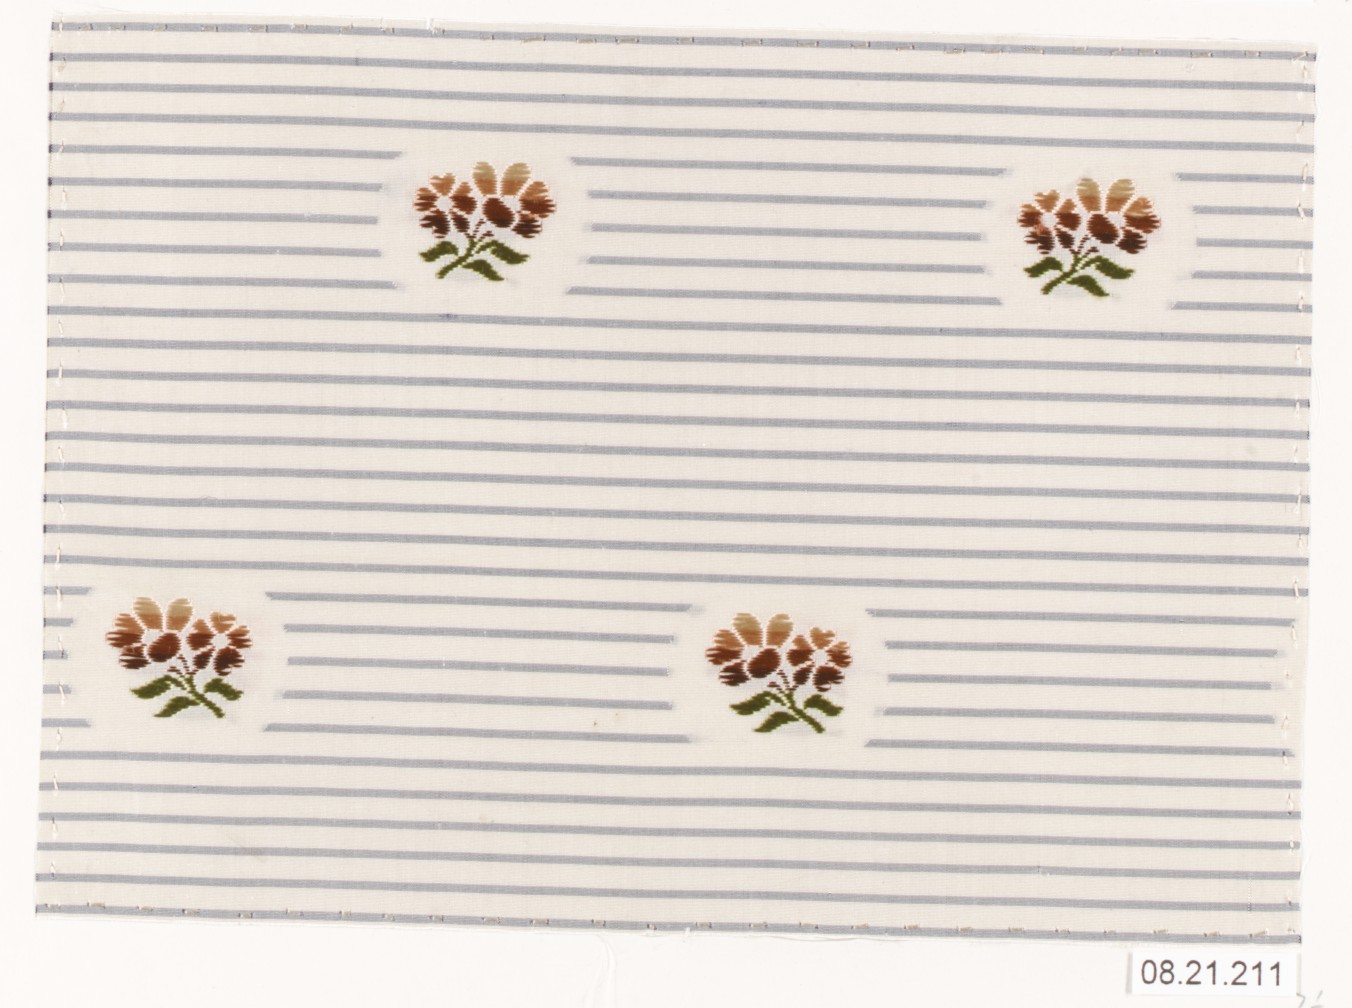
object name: textile sample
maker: Anonymous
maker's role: designer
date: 1900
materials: silk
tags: flowers